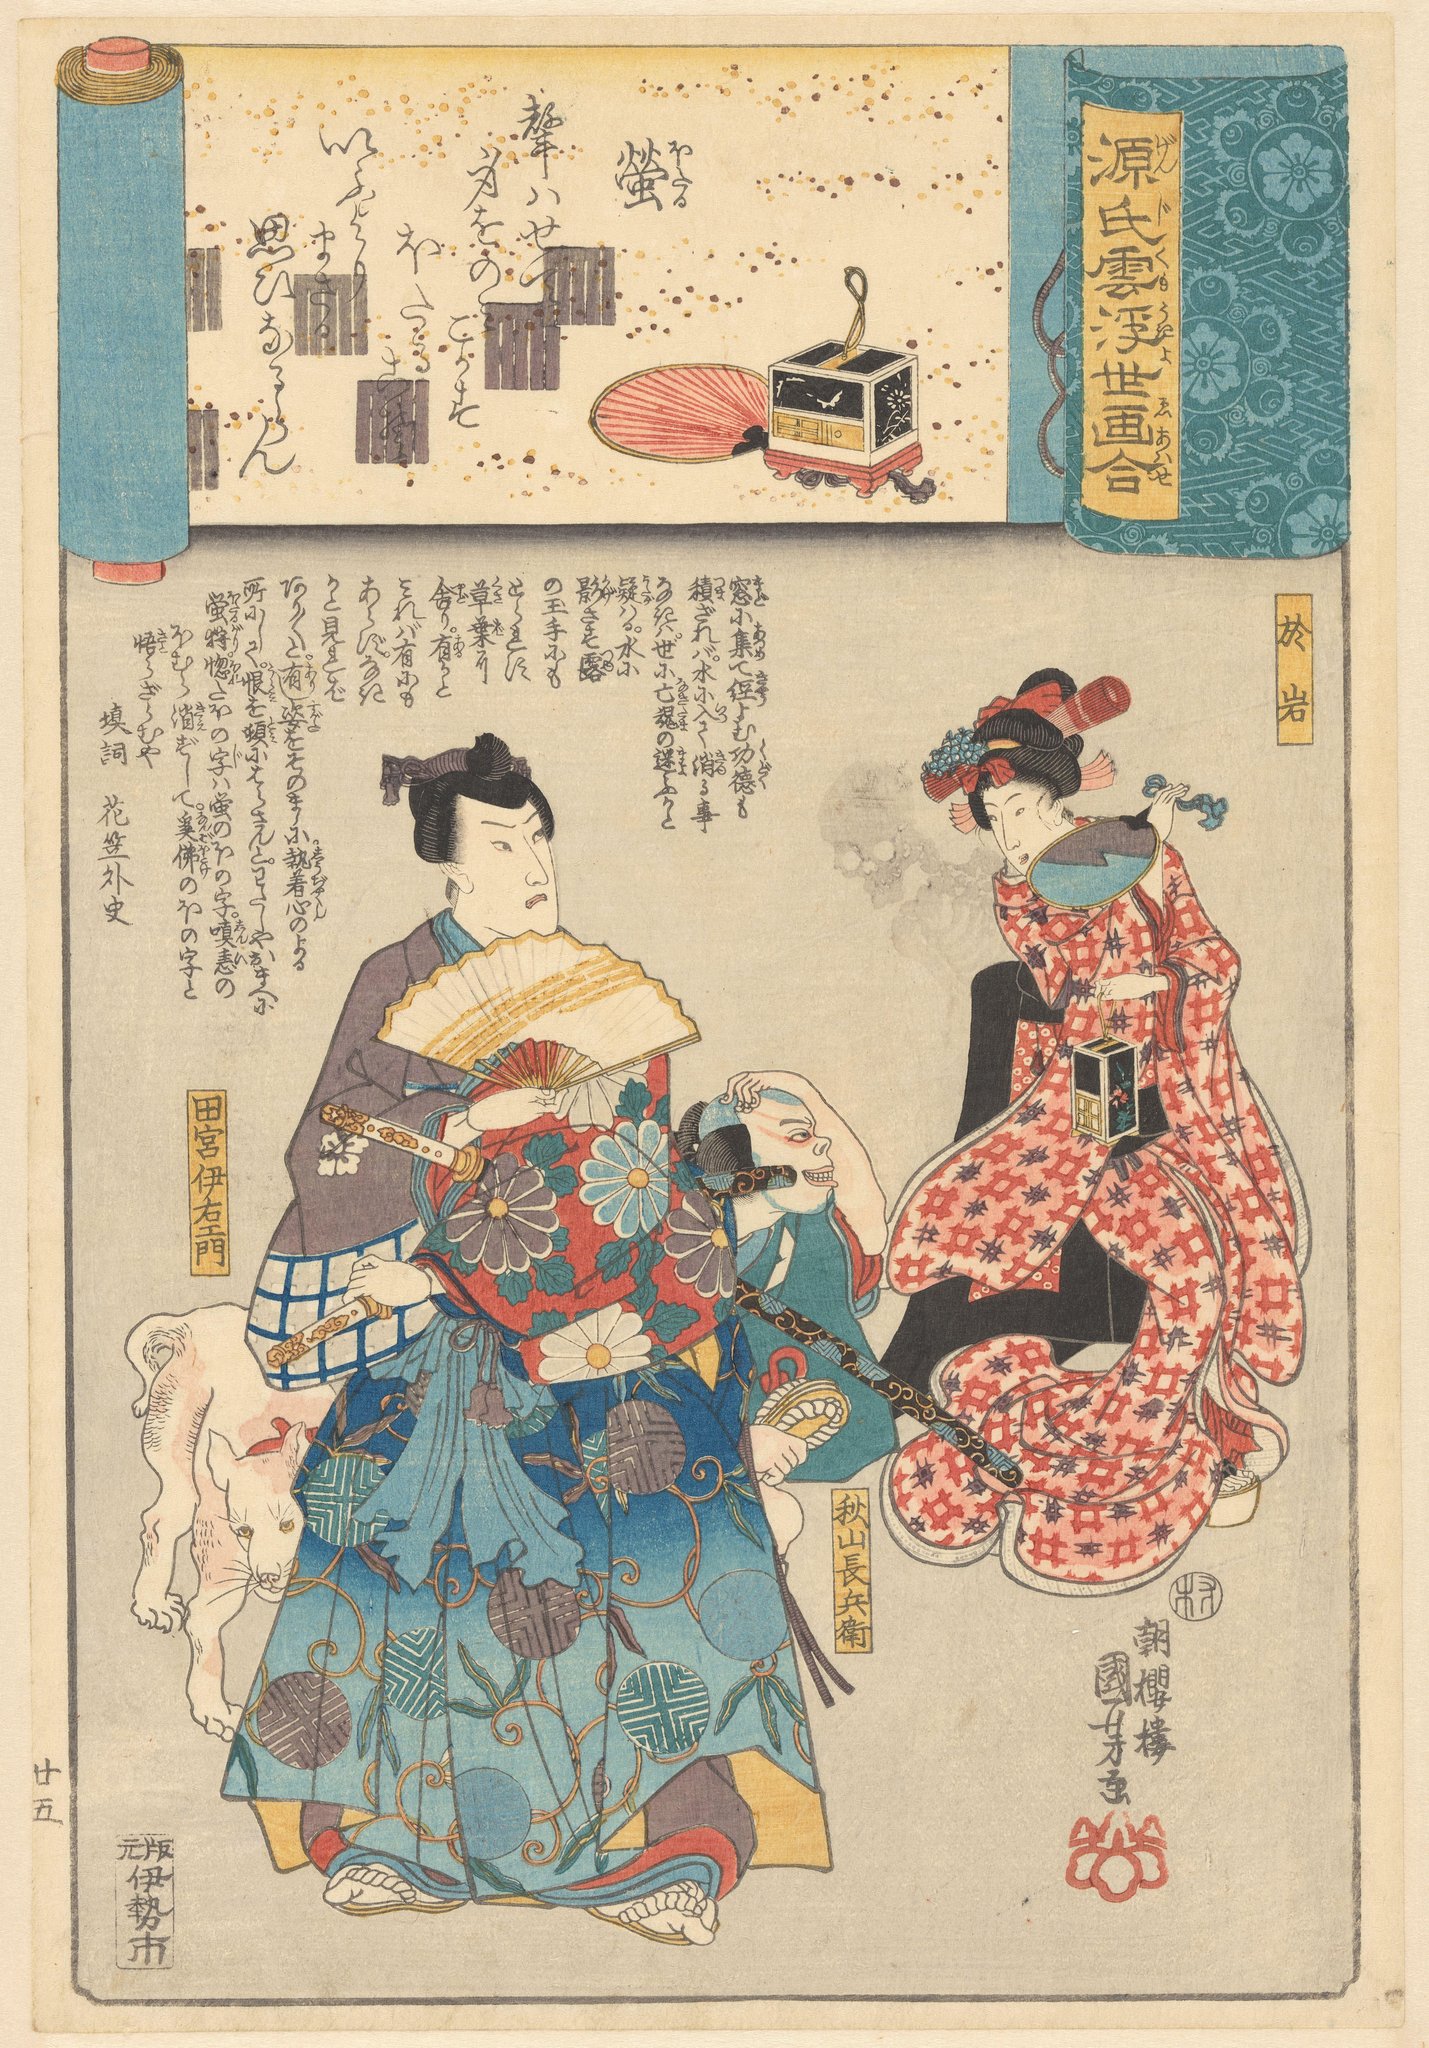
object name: print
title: Ukiyo e parallels to the cloudy chapters of the Genji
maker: utagawa kuniyoshi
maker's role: draughtsman, print maker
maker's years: 1798-1861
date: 1846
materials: paper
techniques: woodcut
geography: japan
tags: fan, spirit, ghost, house personnel, servants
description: Tamiya Iemon met waaier en achter hem zijn bediende Akiyama Chobei, kijken naar de spookverschijning van Iemons vrouw Oiwa. In haar hand draagt Oiwa een kooitje voor vuurvliegjes, maar haar schaduw verraadt dat ze een spookverschijning is. Iemon had zijn vrouw vergif gegeven waardoor ze misvormd werd en zelfmoord pleegde. Uit wraak blijft ze haar man achtervolgen.